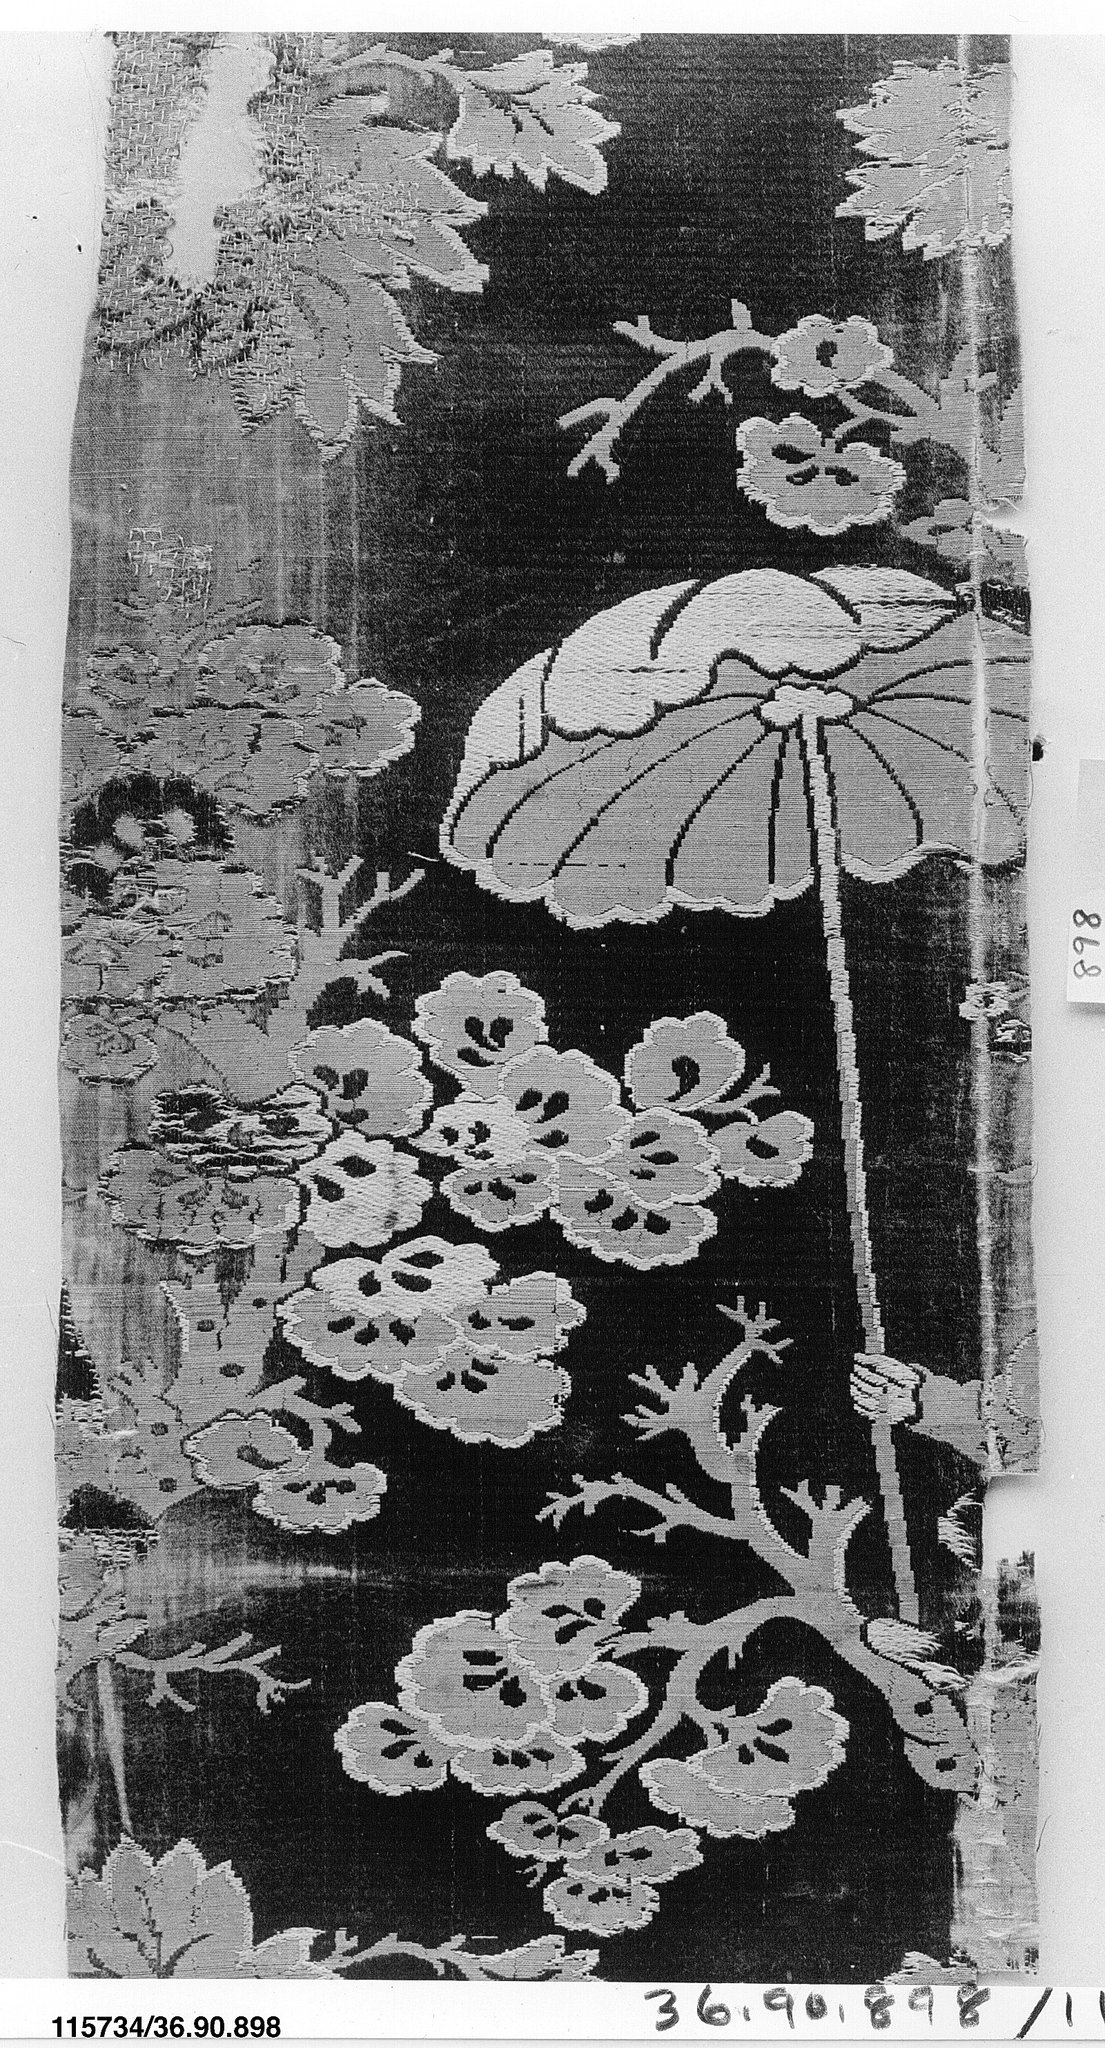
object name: piece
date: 1701-1800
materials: silk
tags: leaves